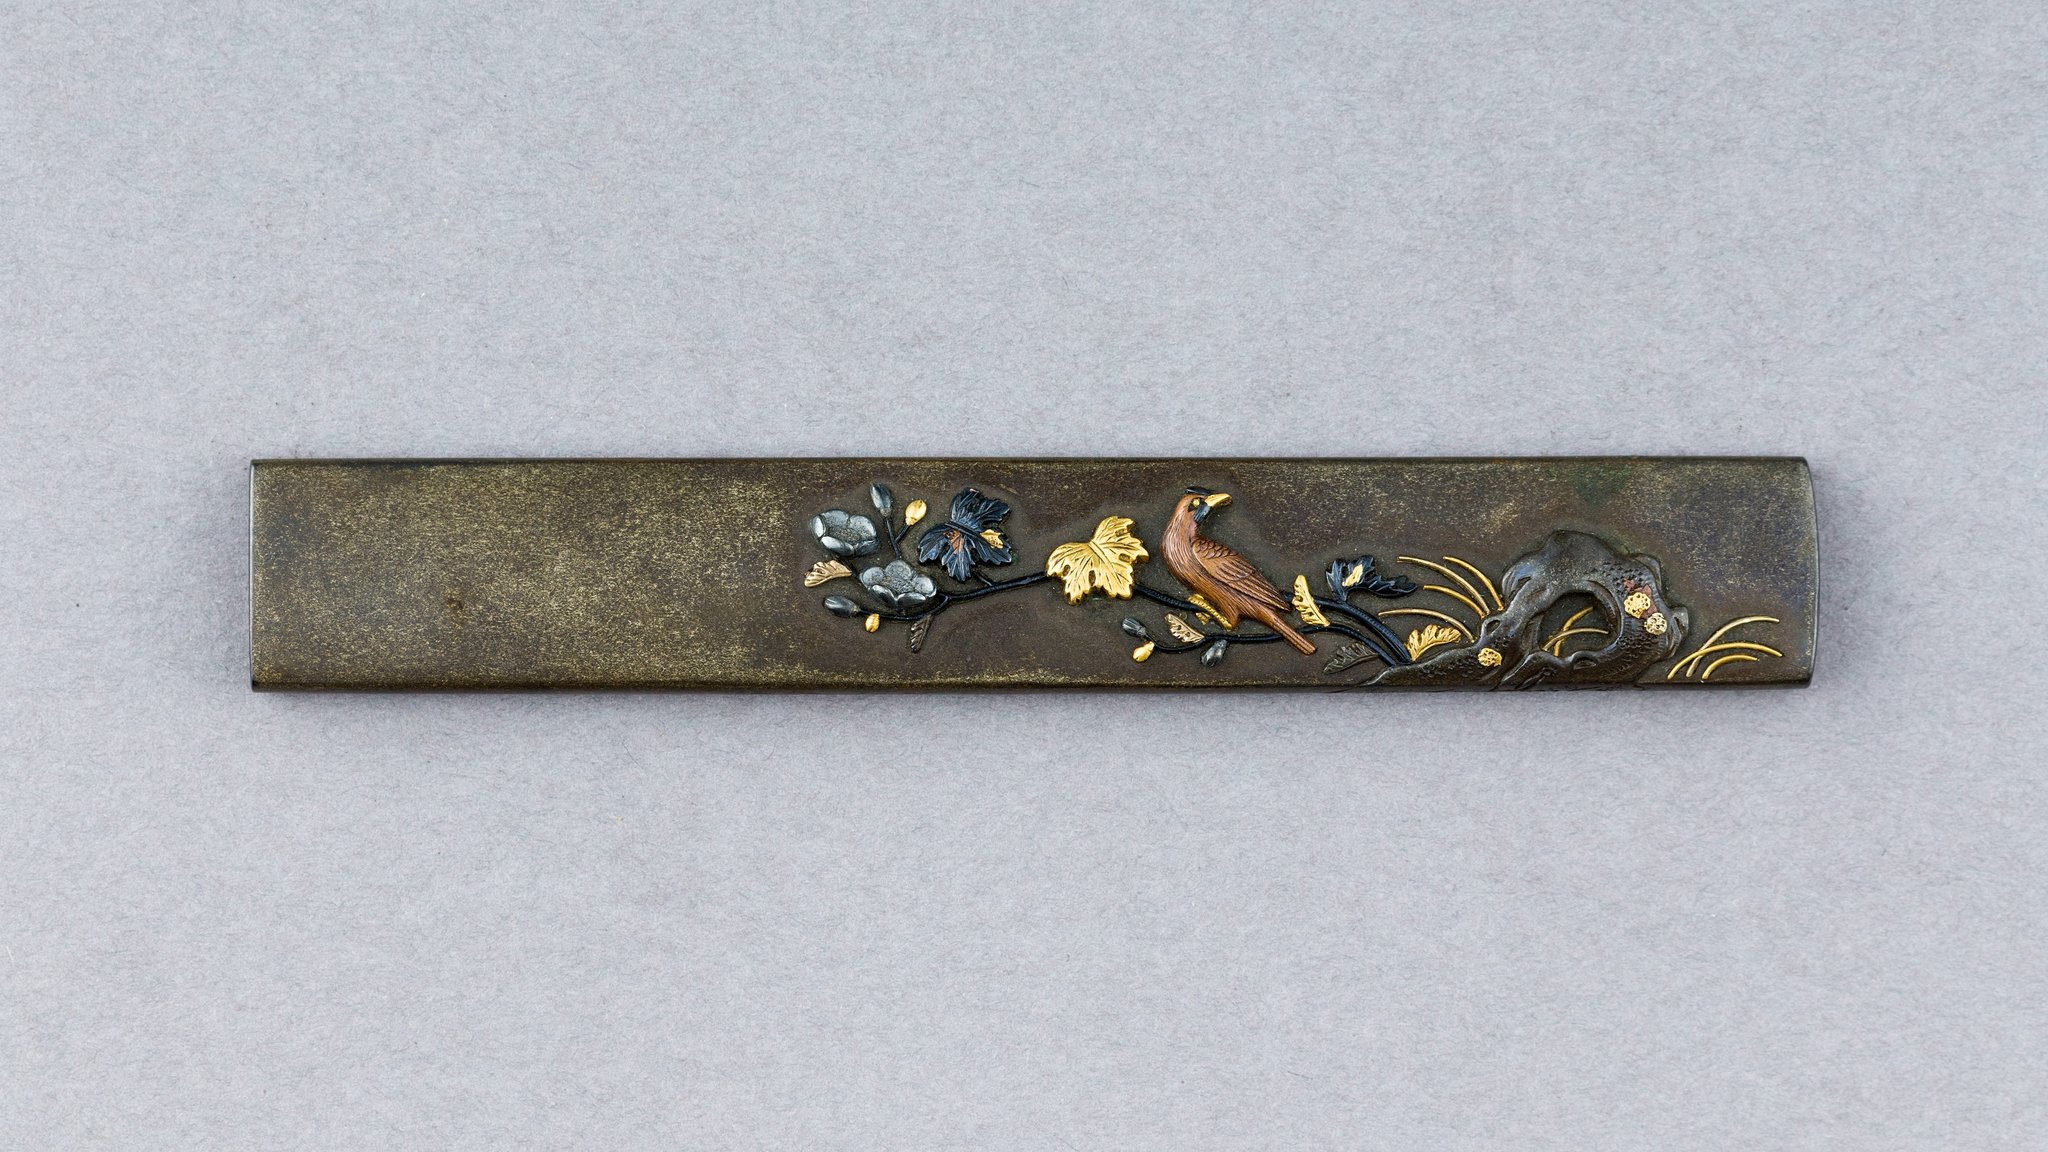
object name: knife handle kozuka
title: Knife Handle (Kozuka)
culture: japanese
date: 1615-1868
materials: copper, gold alloy, silver alloy, gold, silver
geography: japan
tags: birds,flowers